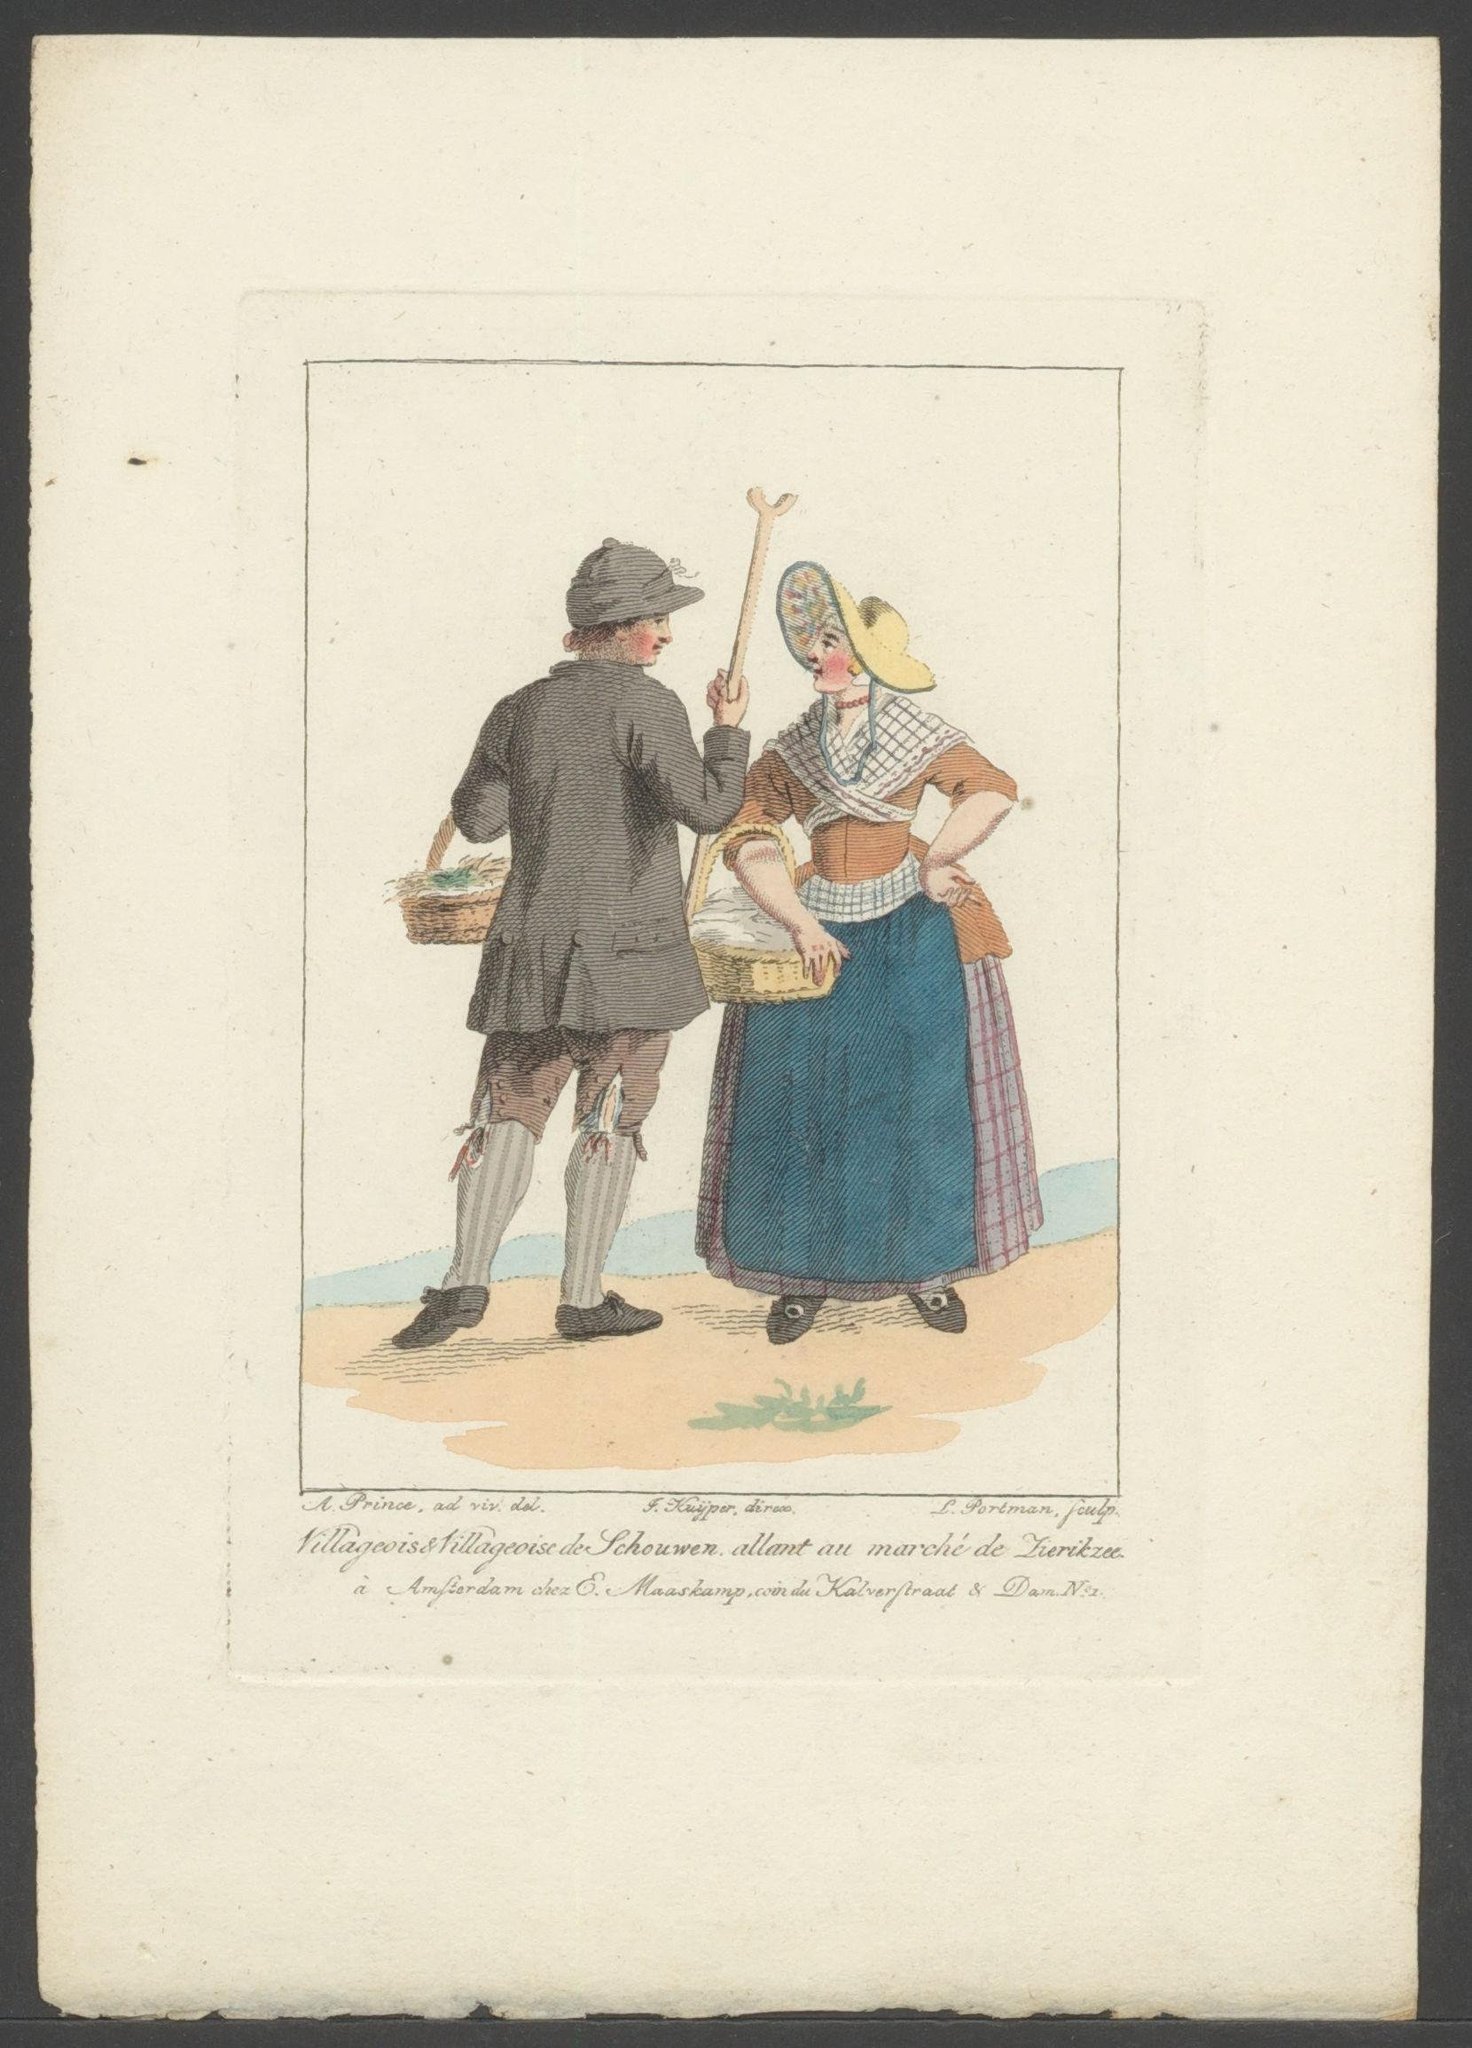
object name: costume print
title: Boer en boerin van Schouwen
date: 1813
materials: paper, watercolor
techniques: etching, hand coloring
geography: netherlands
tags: going to the market, farmers, farmers - aa - female farmer, farmer's wife, clothes, costume (+ women's clothes), carrying something in basket, bag, rucksack, etc., clothes, costume (+ men's clothes), folk costume, regional costume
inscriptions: collector's mark: Lugt 1641, collector's mark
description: Boer en boerin van Schouwen samen onderweg naar de markt in Zierikzee. Bij de prent zit ook een blad met de Franse titel. Onderdeel van de verkleinde kopieën uit 1812 naar de platen van Nederlandse klederdrachten uit de jaren 1803-1807. Onderwerpsrubrieken binnen de Atlas Zeden en Gewoonten: De Kleeding, Volkskleederdracht.